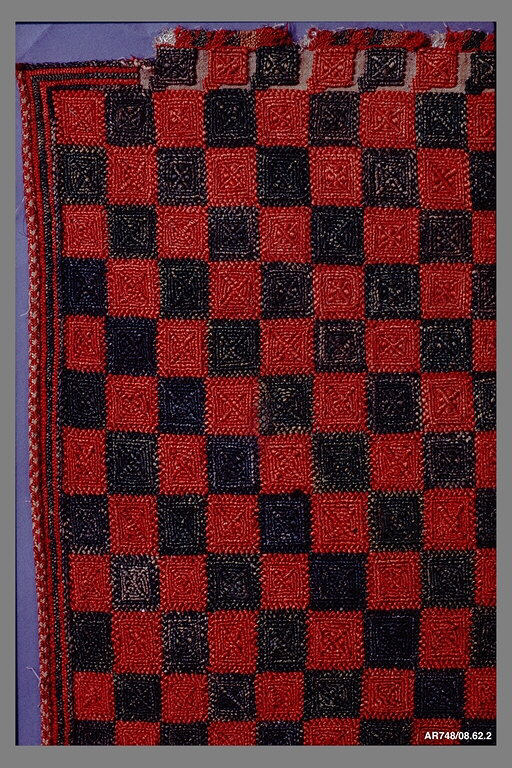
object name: sleeve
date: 1701-1800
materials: silk